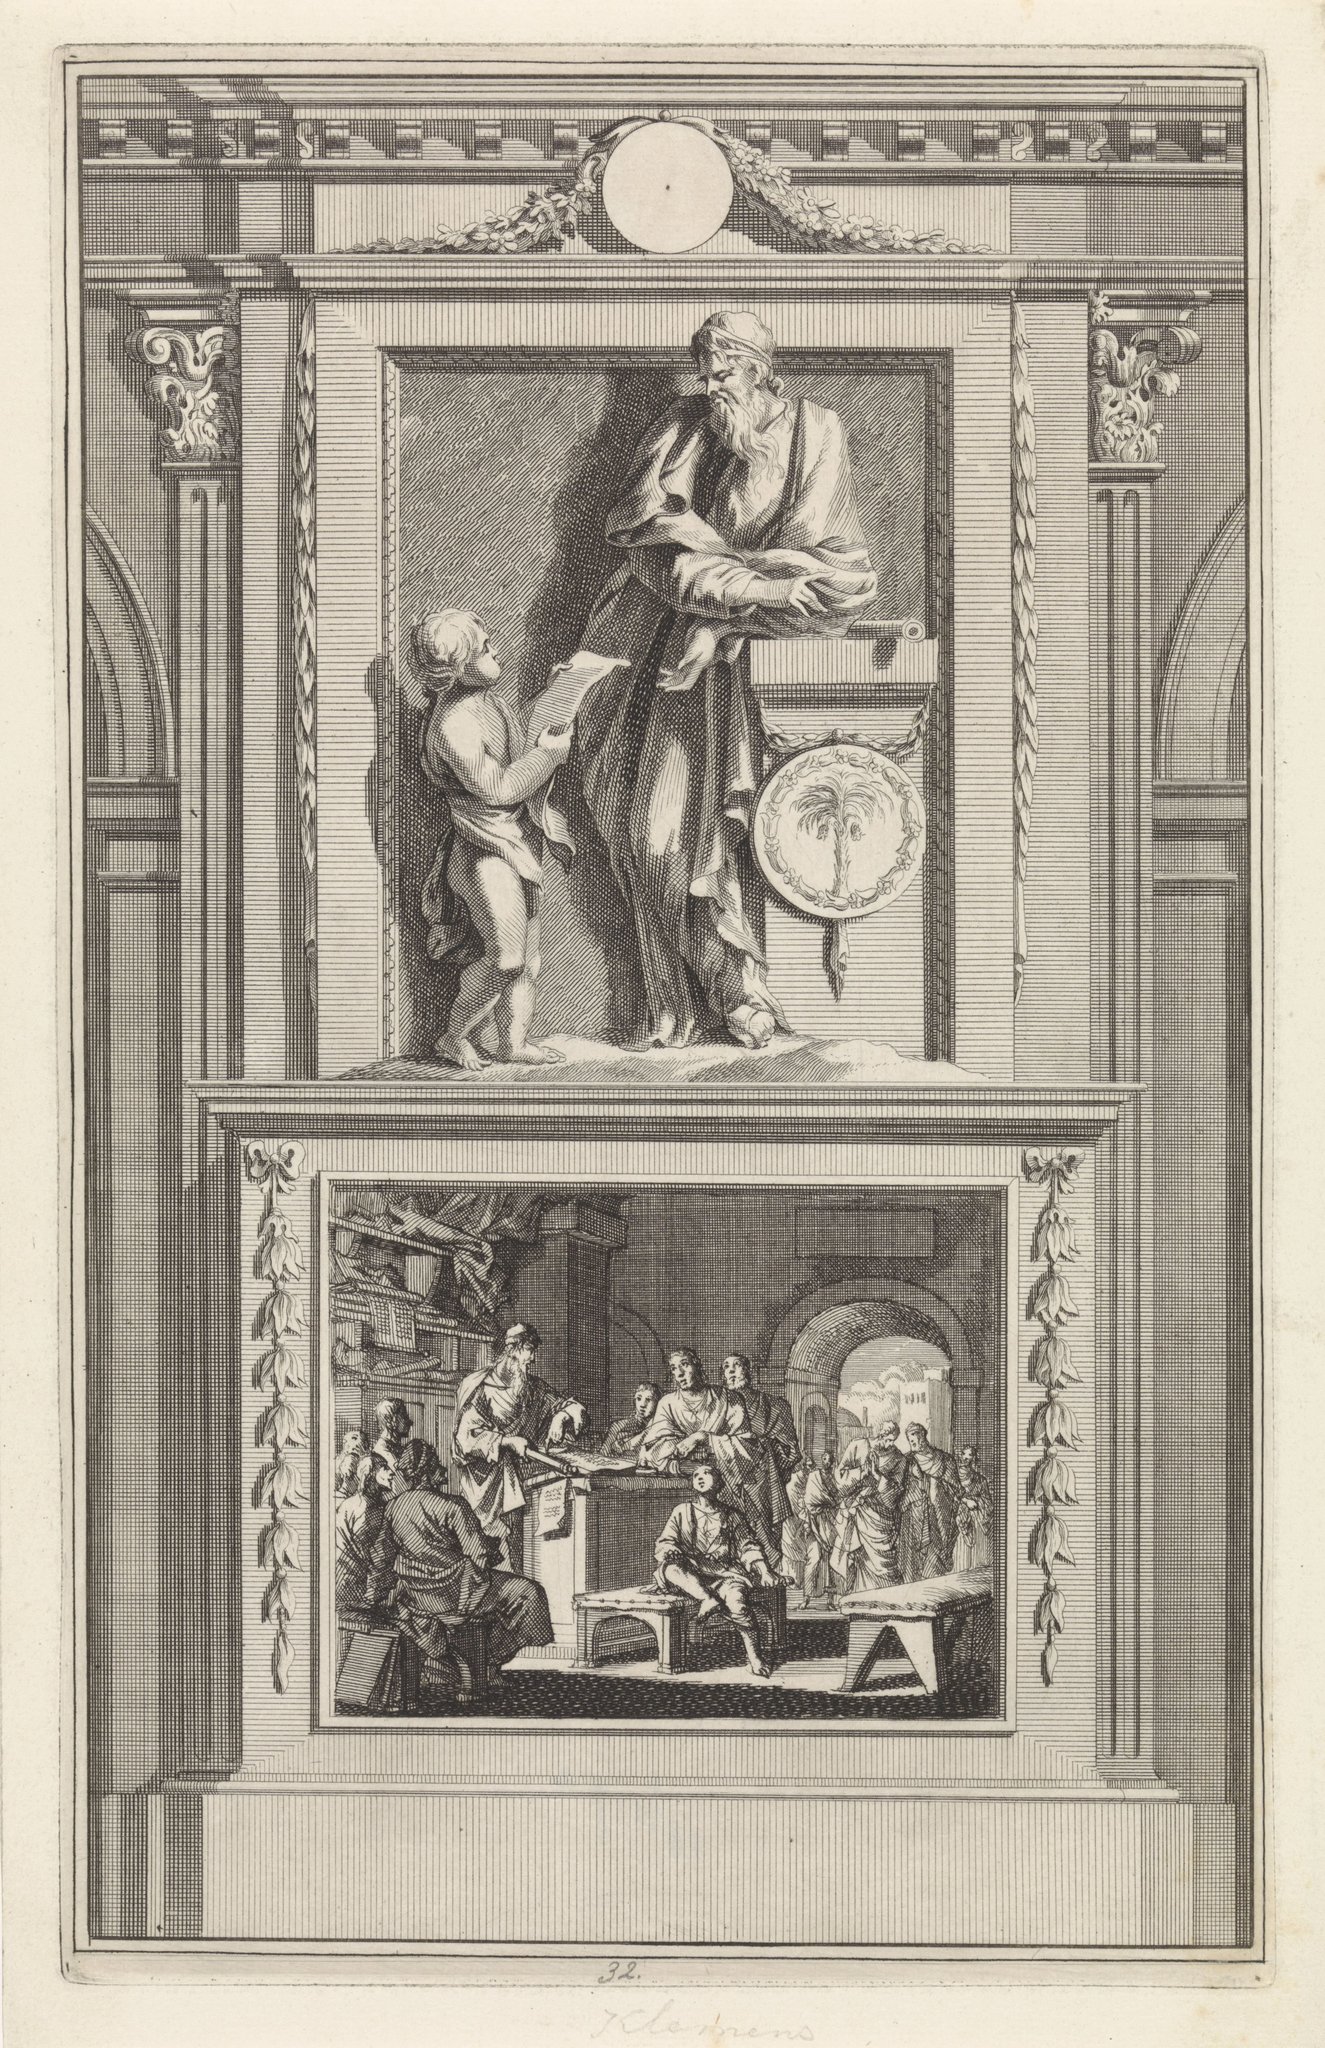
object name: print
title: H. Clemens van Alexandrië, kerkvader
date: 1698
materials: paper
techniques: engraving, etching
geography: amsterdam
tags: male saints (clemens of alexandria) - male saint writing, studying, teaching, dictating (e.g. as doctor of the church), male saints (clemens of alexandria)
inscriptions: collector's mark: Lugt 2228, number: ‘32’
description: De heilige kerkvader Clemens van Alexandrië luisterend naar een engel die hem een tekst voorleest. Clemens staat op een sokkel waar op de voorzijde zijn onderricht in de School van Alexandrië in beeld is gebracht.